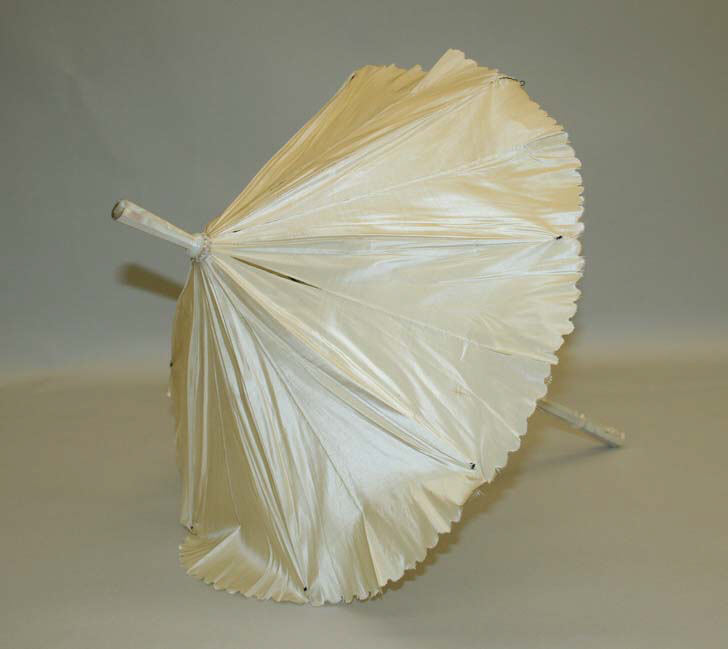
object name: parasol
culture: american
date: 1860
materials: mother of pearl, silk